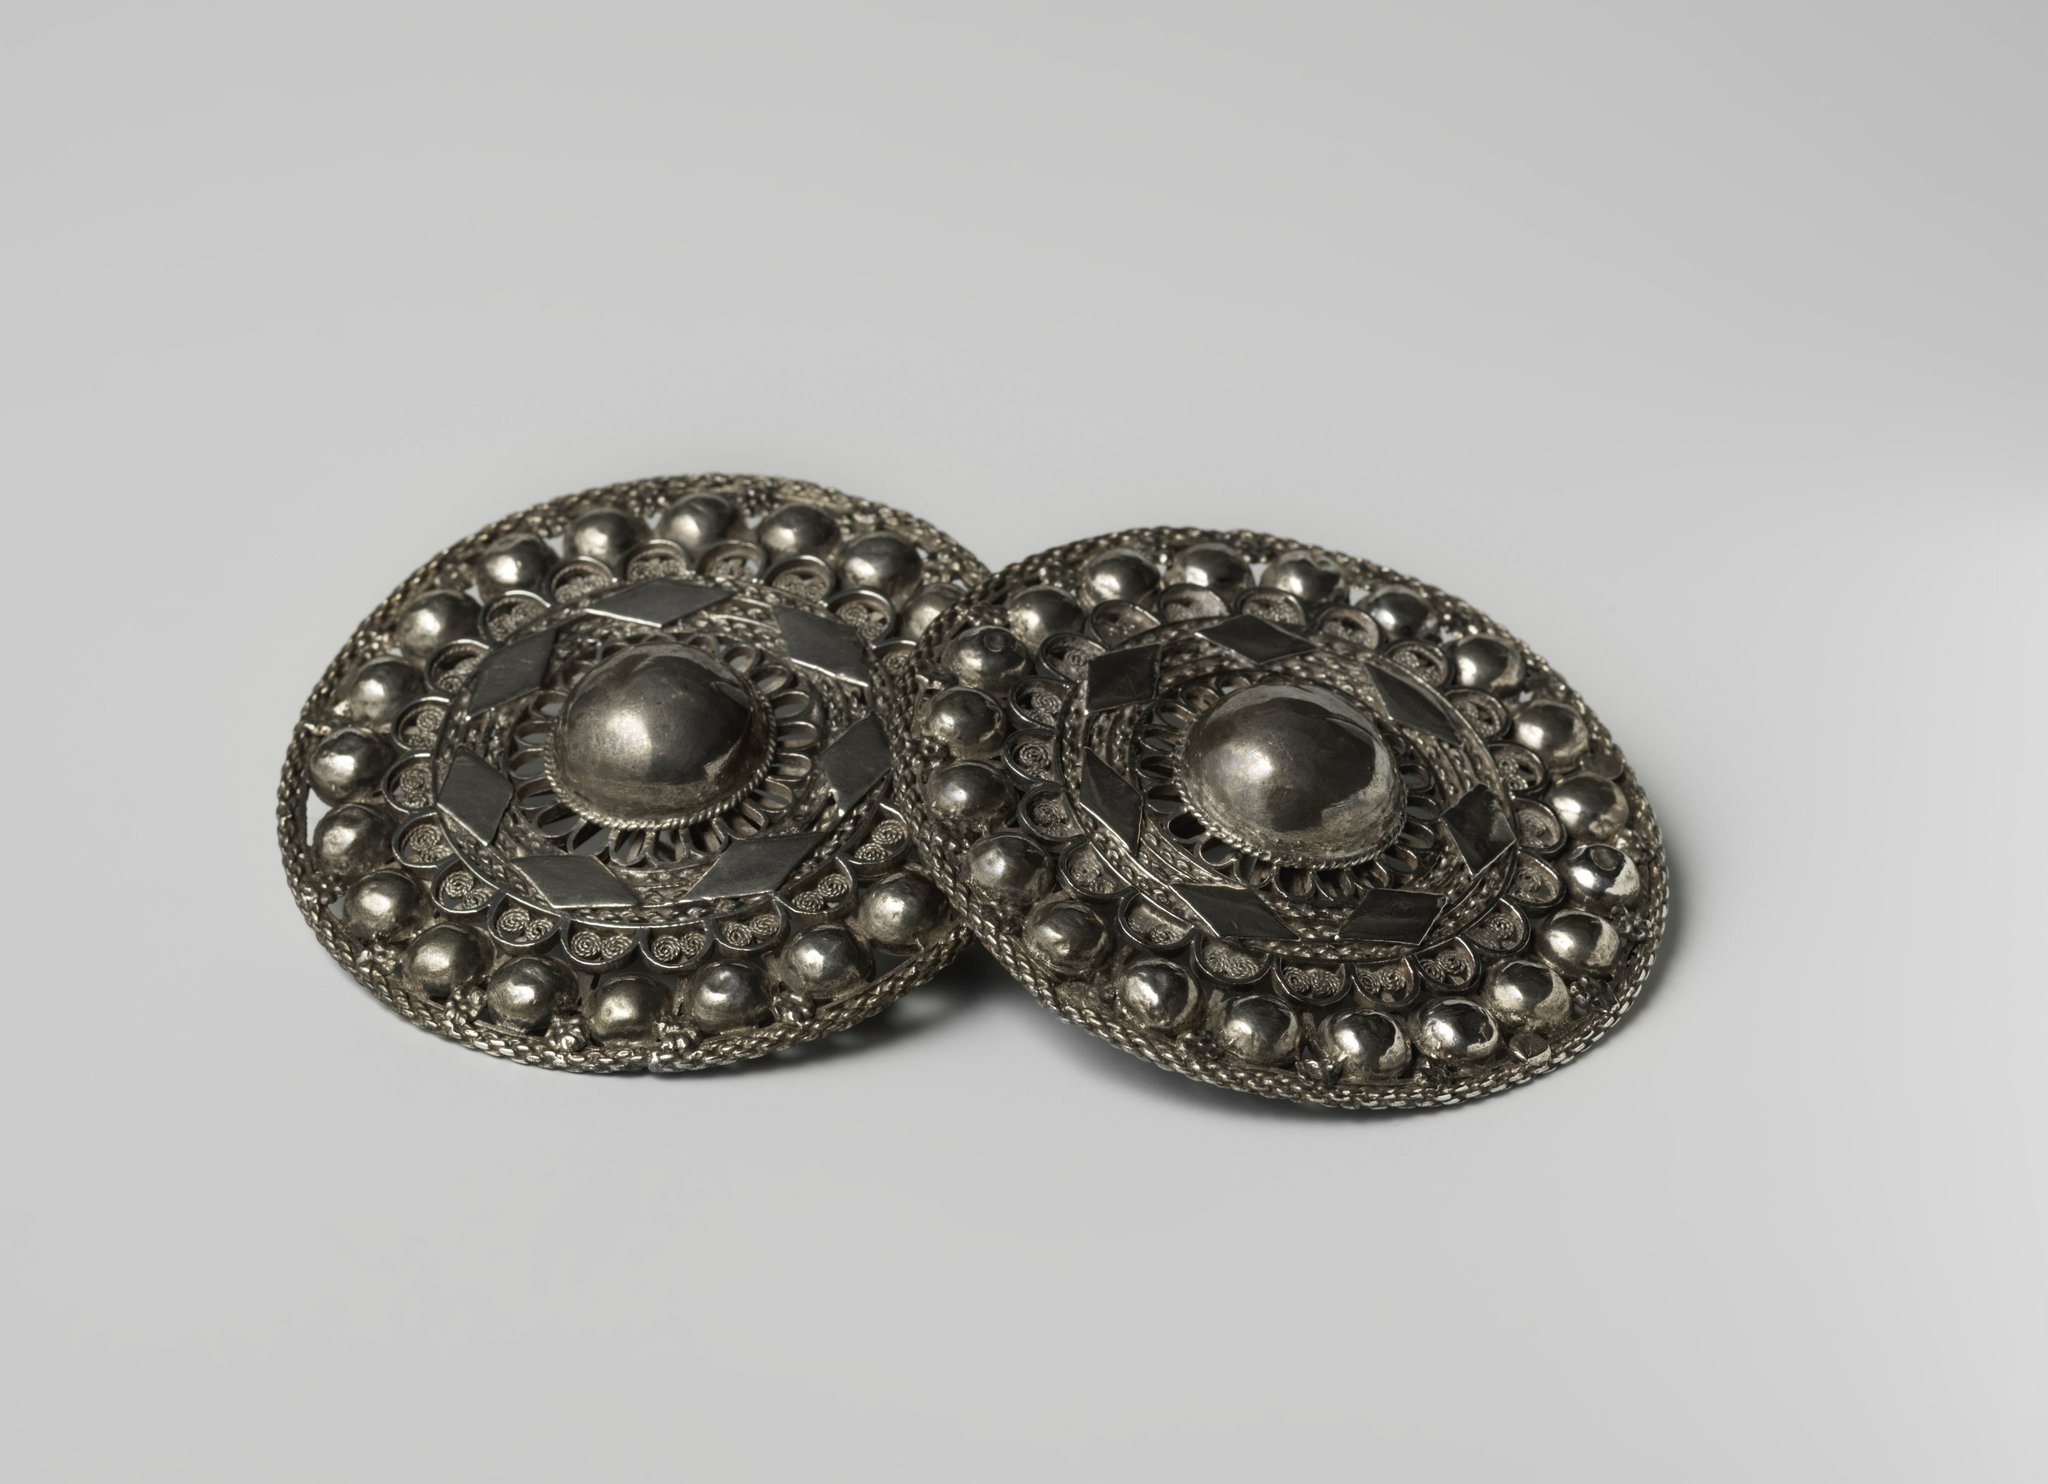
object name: button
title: Twee grote ronde Zeeuwse knopen van zilver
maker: Anonymous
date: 1858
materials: silver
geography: netherlands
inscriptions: mark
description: Twee grote ronde Zeeuwse knopen van zilver. Rond met een grove parelrand om een rozet die door festons is afgezet. In het midden een halve bol omringd door opengewerkte boogjes. Daar omheen een rand van ruiten. De knopen zijn door een zilveren schakel verbonden.